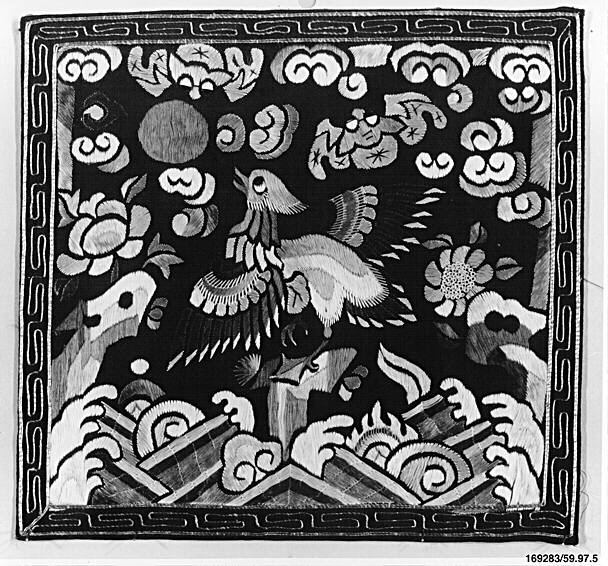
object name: child's rank badge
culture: chinese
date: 1701-1800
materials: silk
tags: bats,ducks